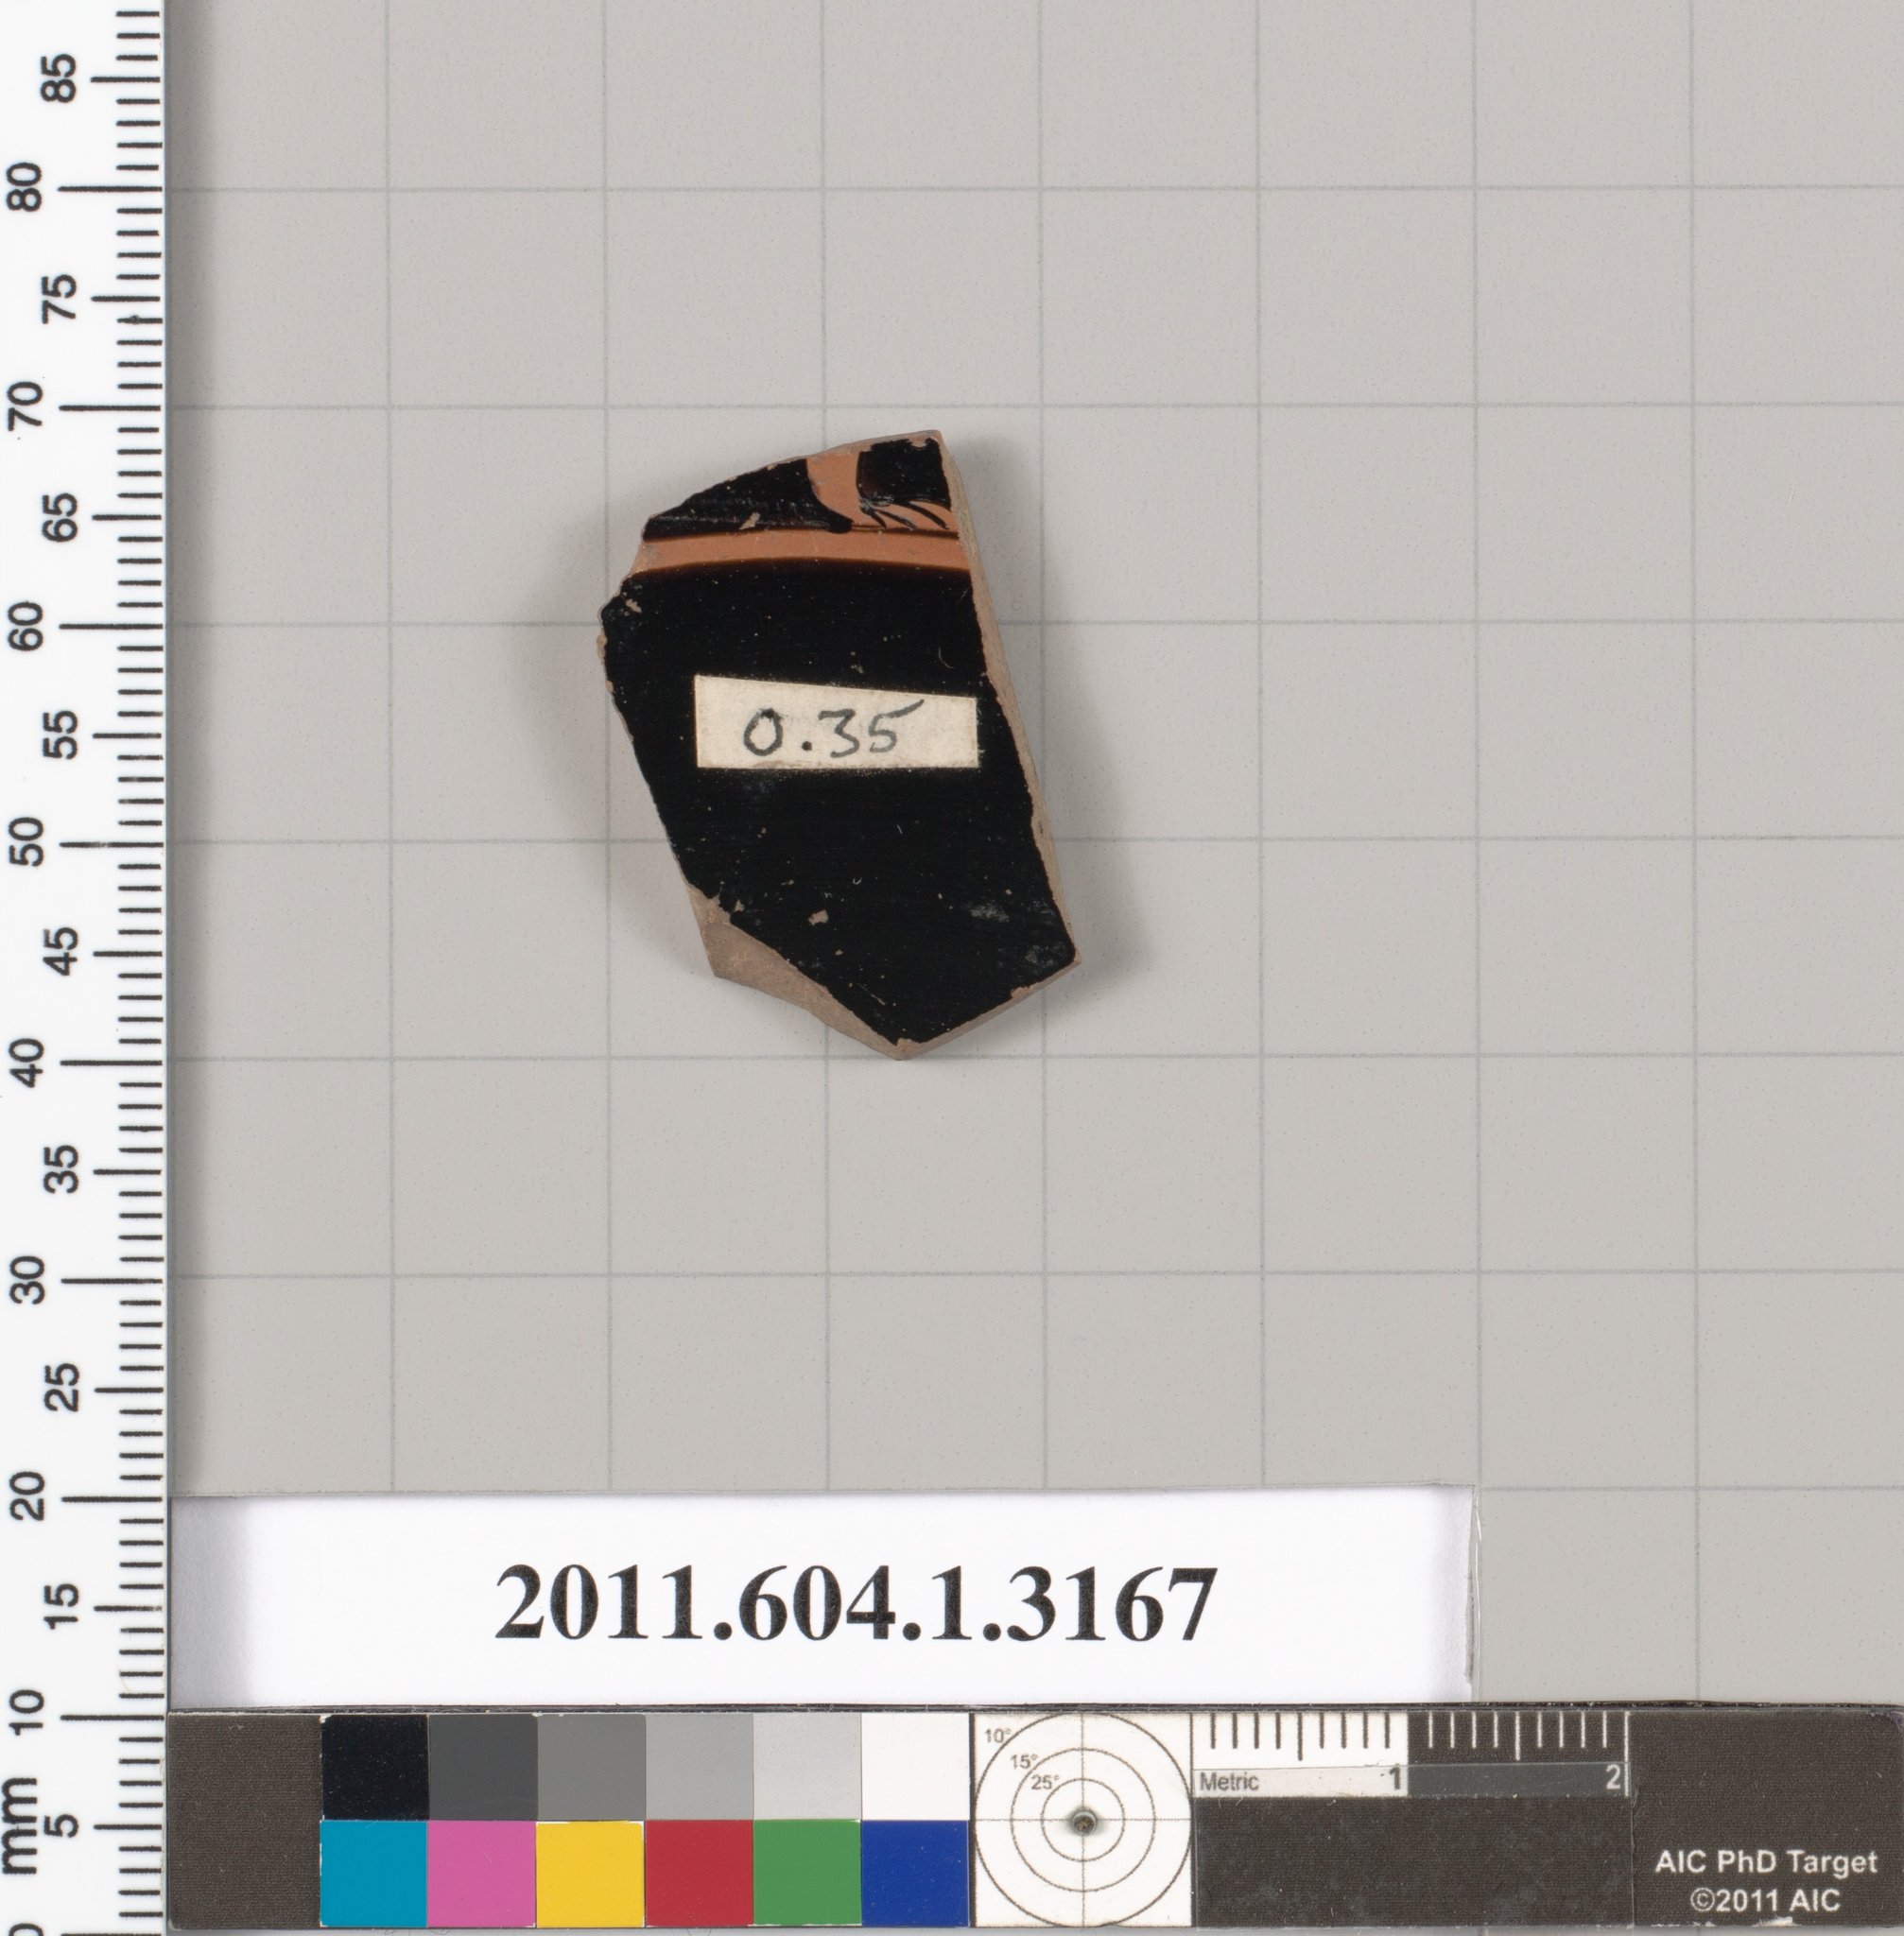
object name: kylix fragment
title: Terracotta fragment of a kylix (drinking cup)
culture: greek, attic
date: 510-490 BCE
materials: terracotta